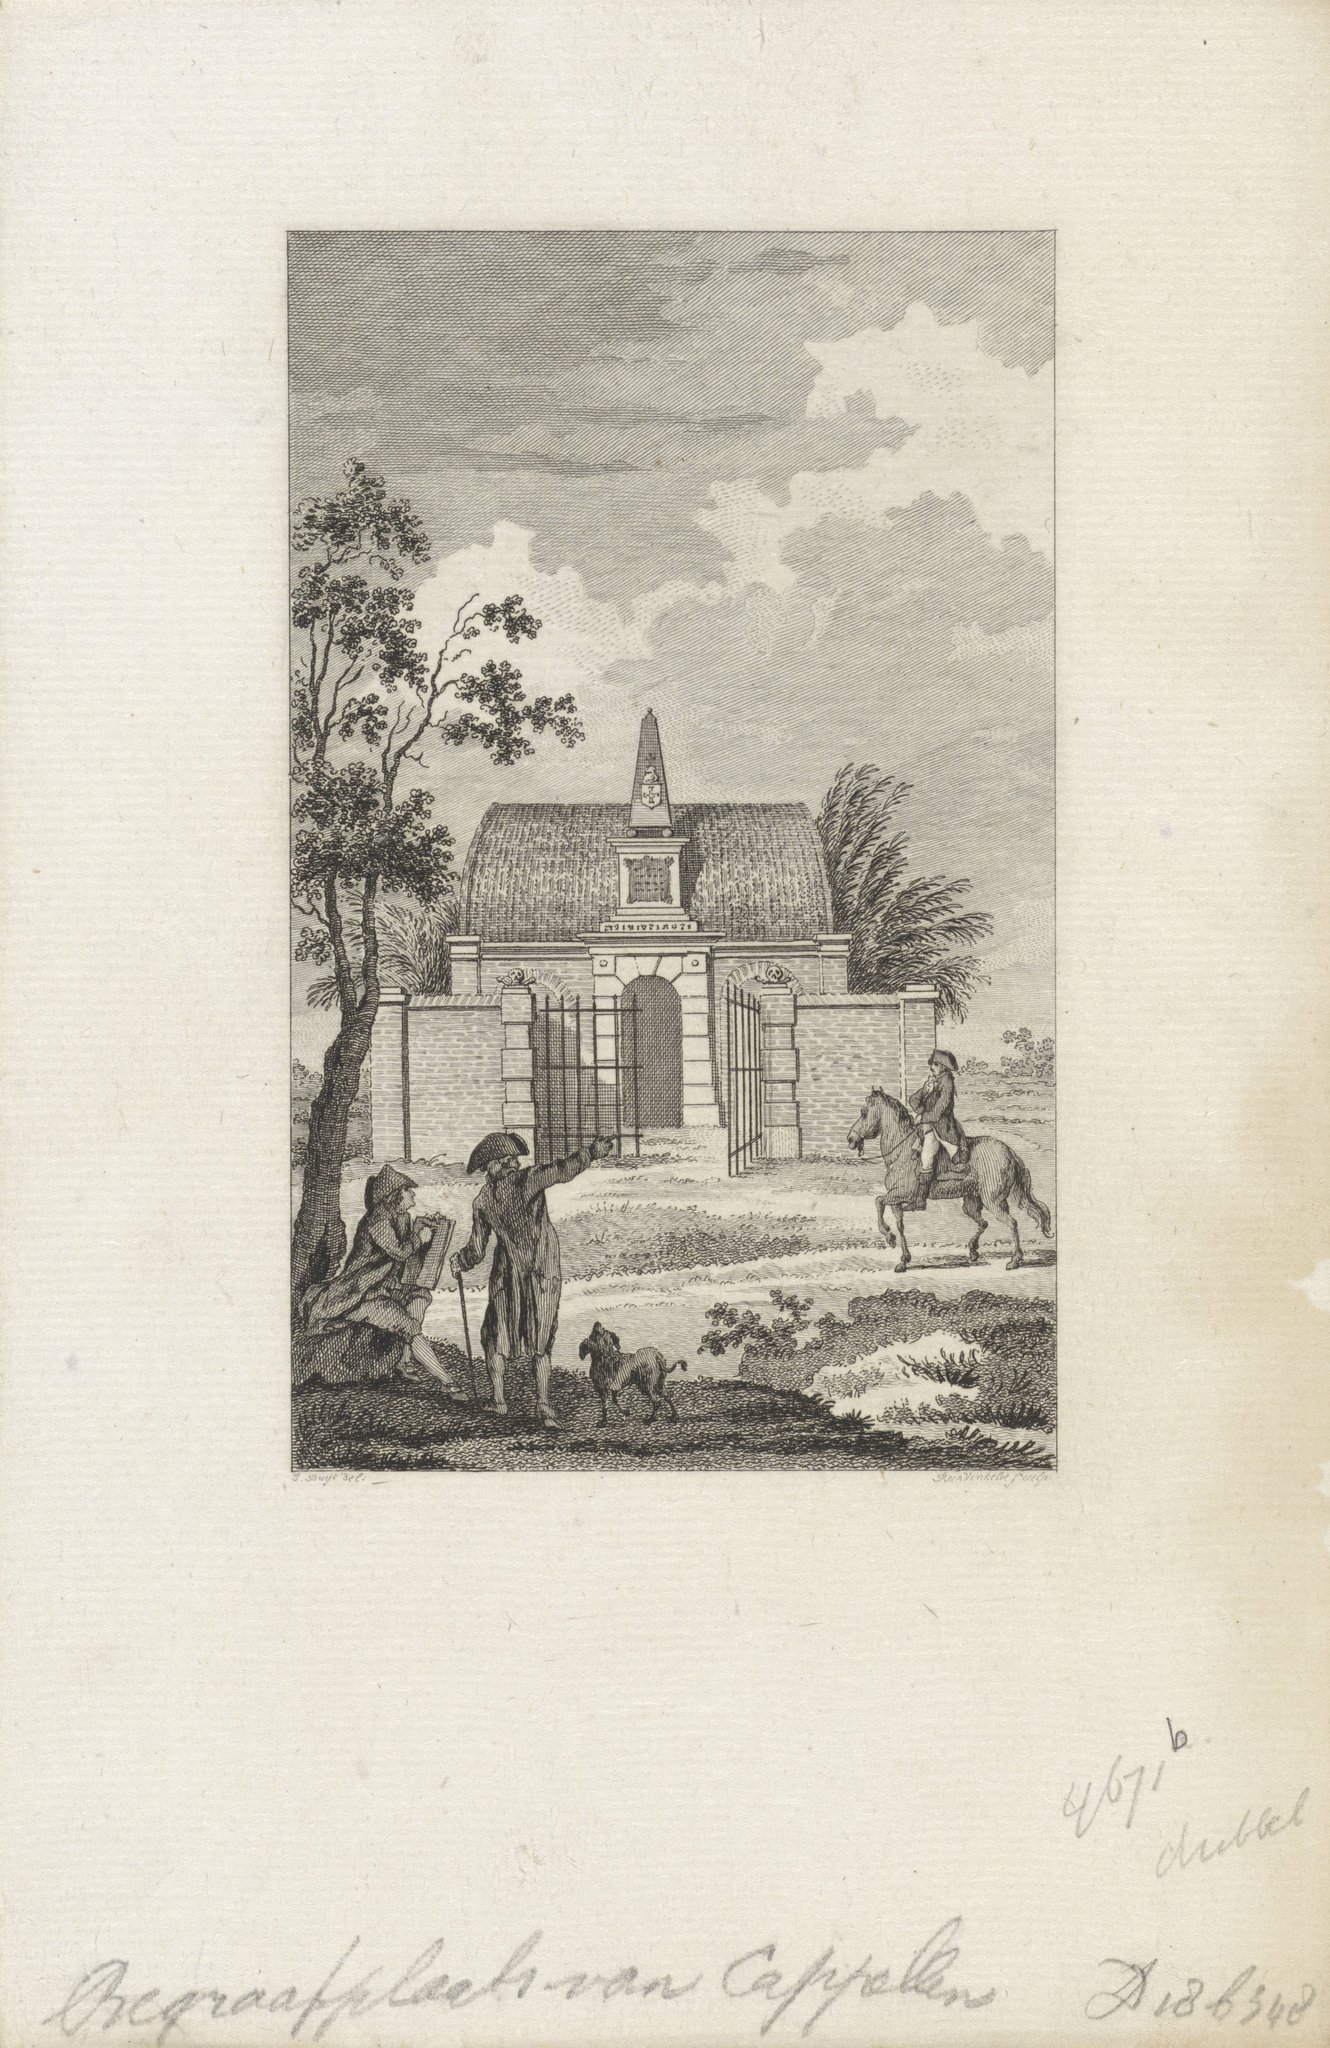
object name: print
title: Begraafplaats van de familie Van der Capellen, 1785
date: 1797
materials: paper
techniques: engraving, etching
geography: amsterdam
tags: politician, joan derk van der capellen tot den pol, grave-building, monumental tomb, patriots (1780-1795)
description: Gebruikt als illustratie in een onbekend werk. Niet, zoals Muller vermeldt, gebruikt als illustratie in: Jacobus Kok, Vaderlandsch Woordenboek, Johannes Allart, Amsterdam 1785-1799, 35 delen.